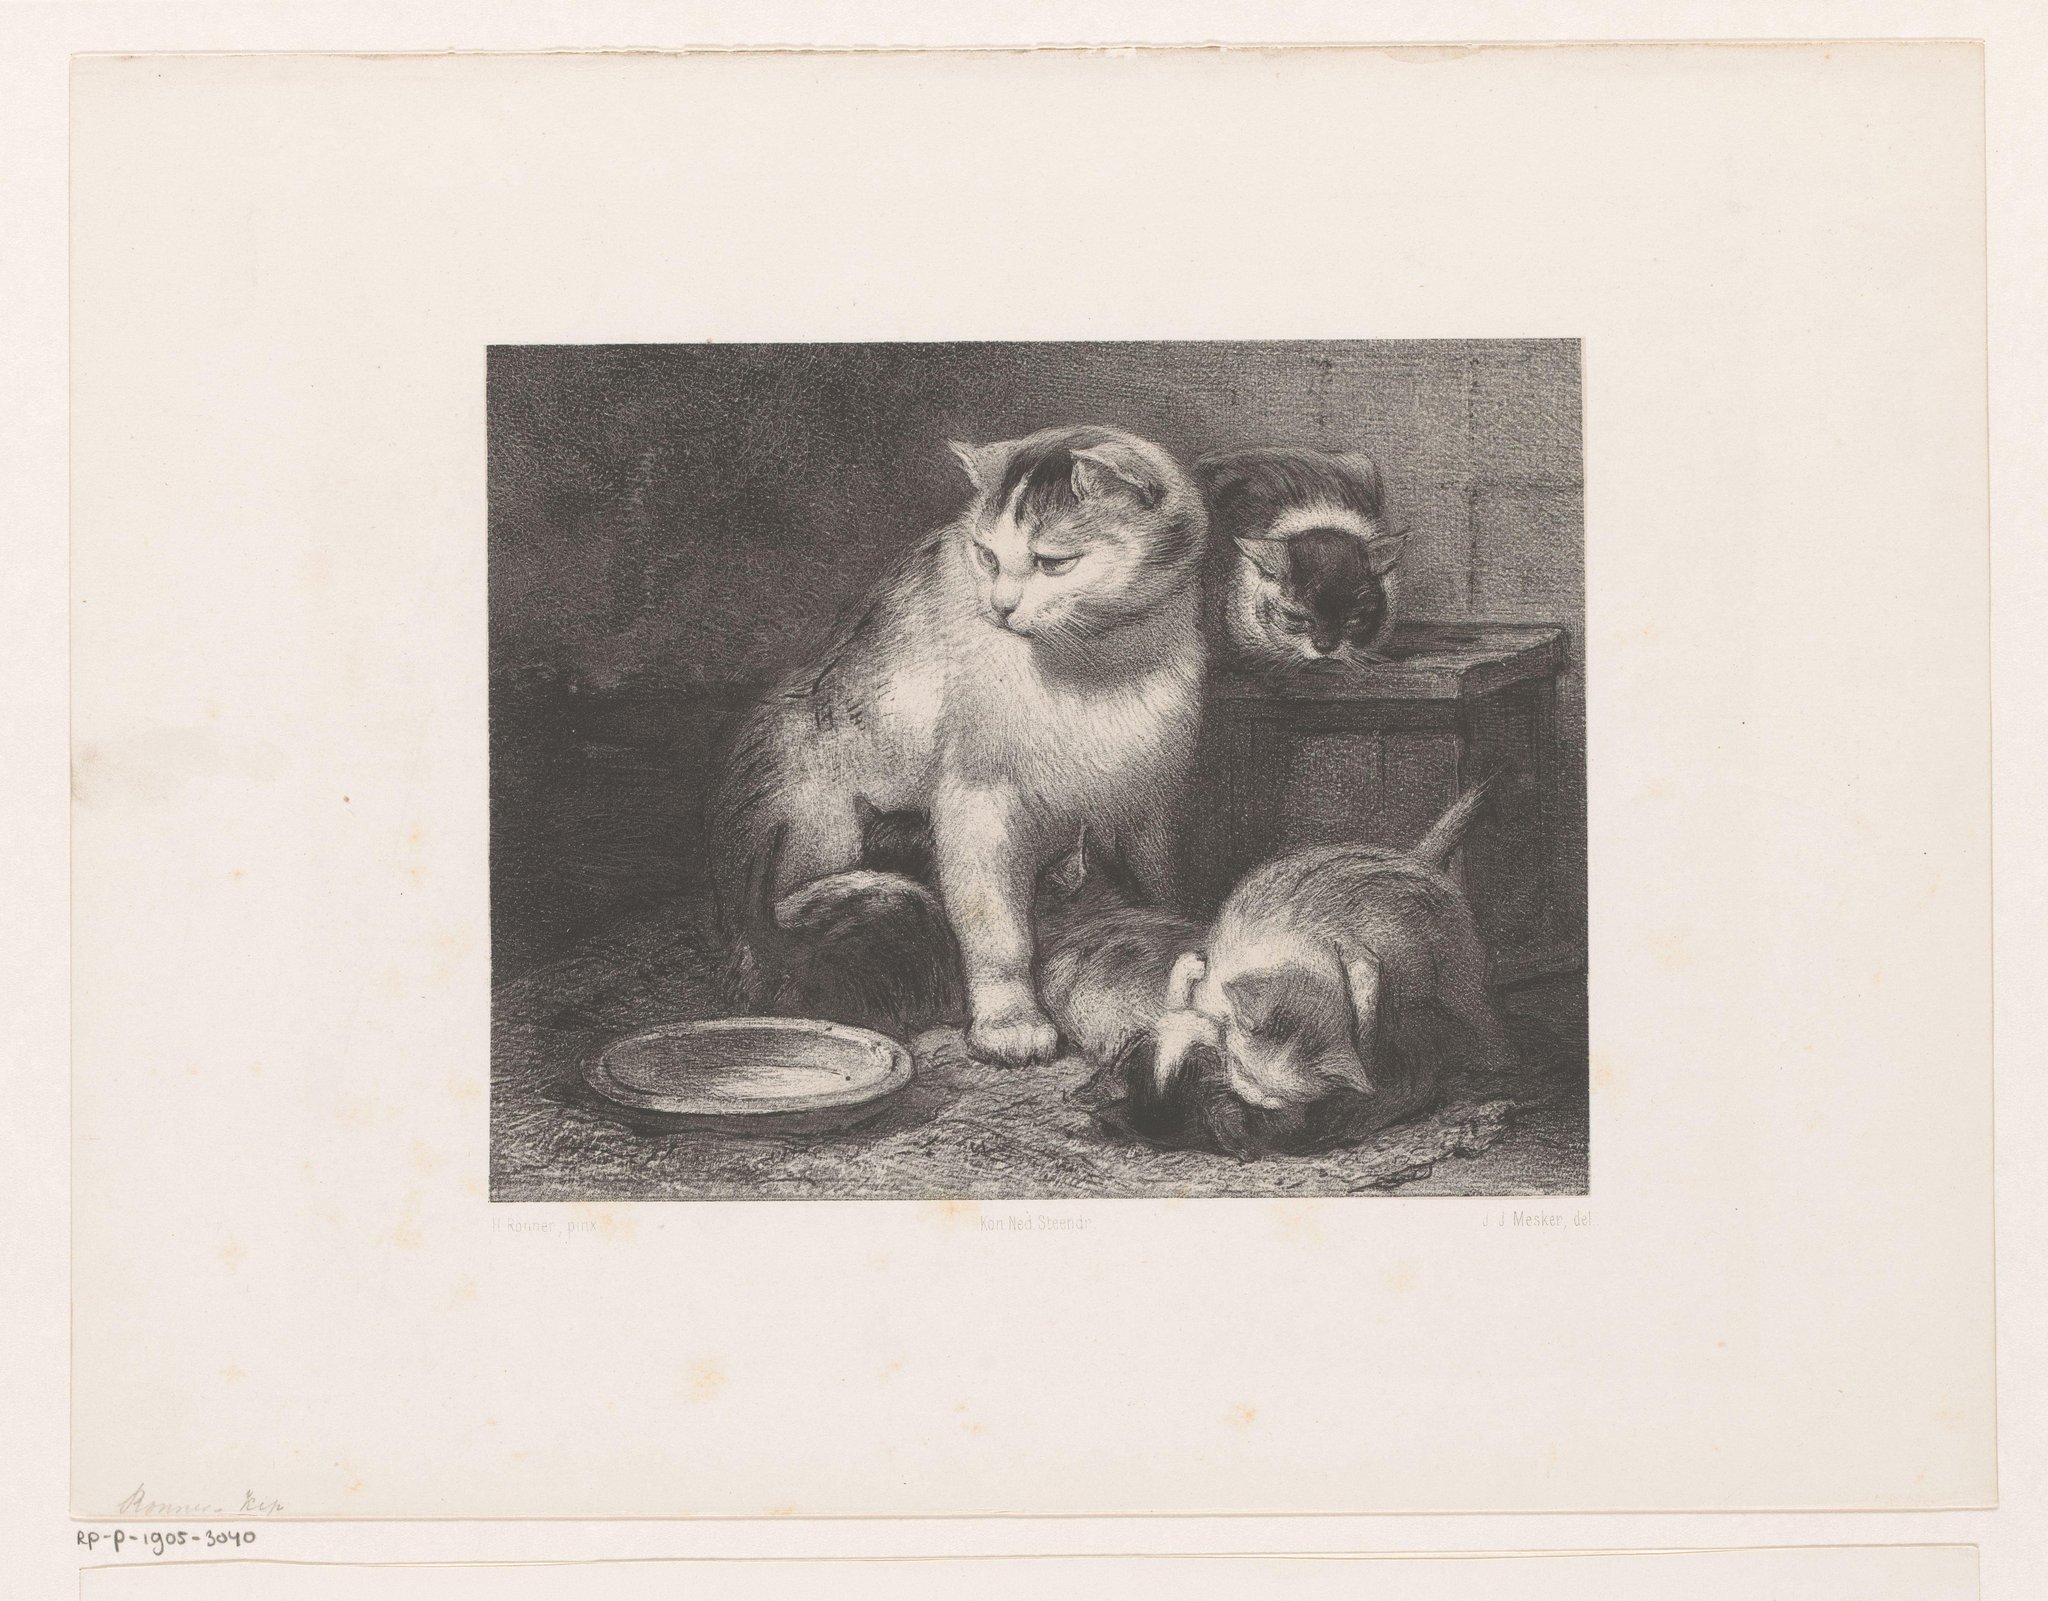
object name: print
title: Poes met jongen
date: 1867-1874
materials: paper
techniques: lithograph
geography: the hague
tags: cat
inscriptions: collector's mark: Lugt 2228